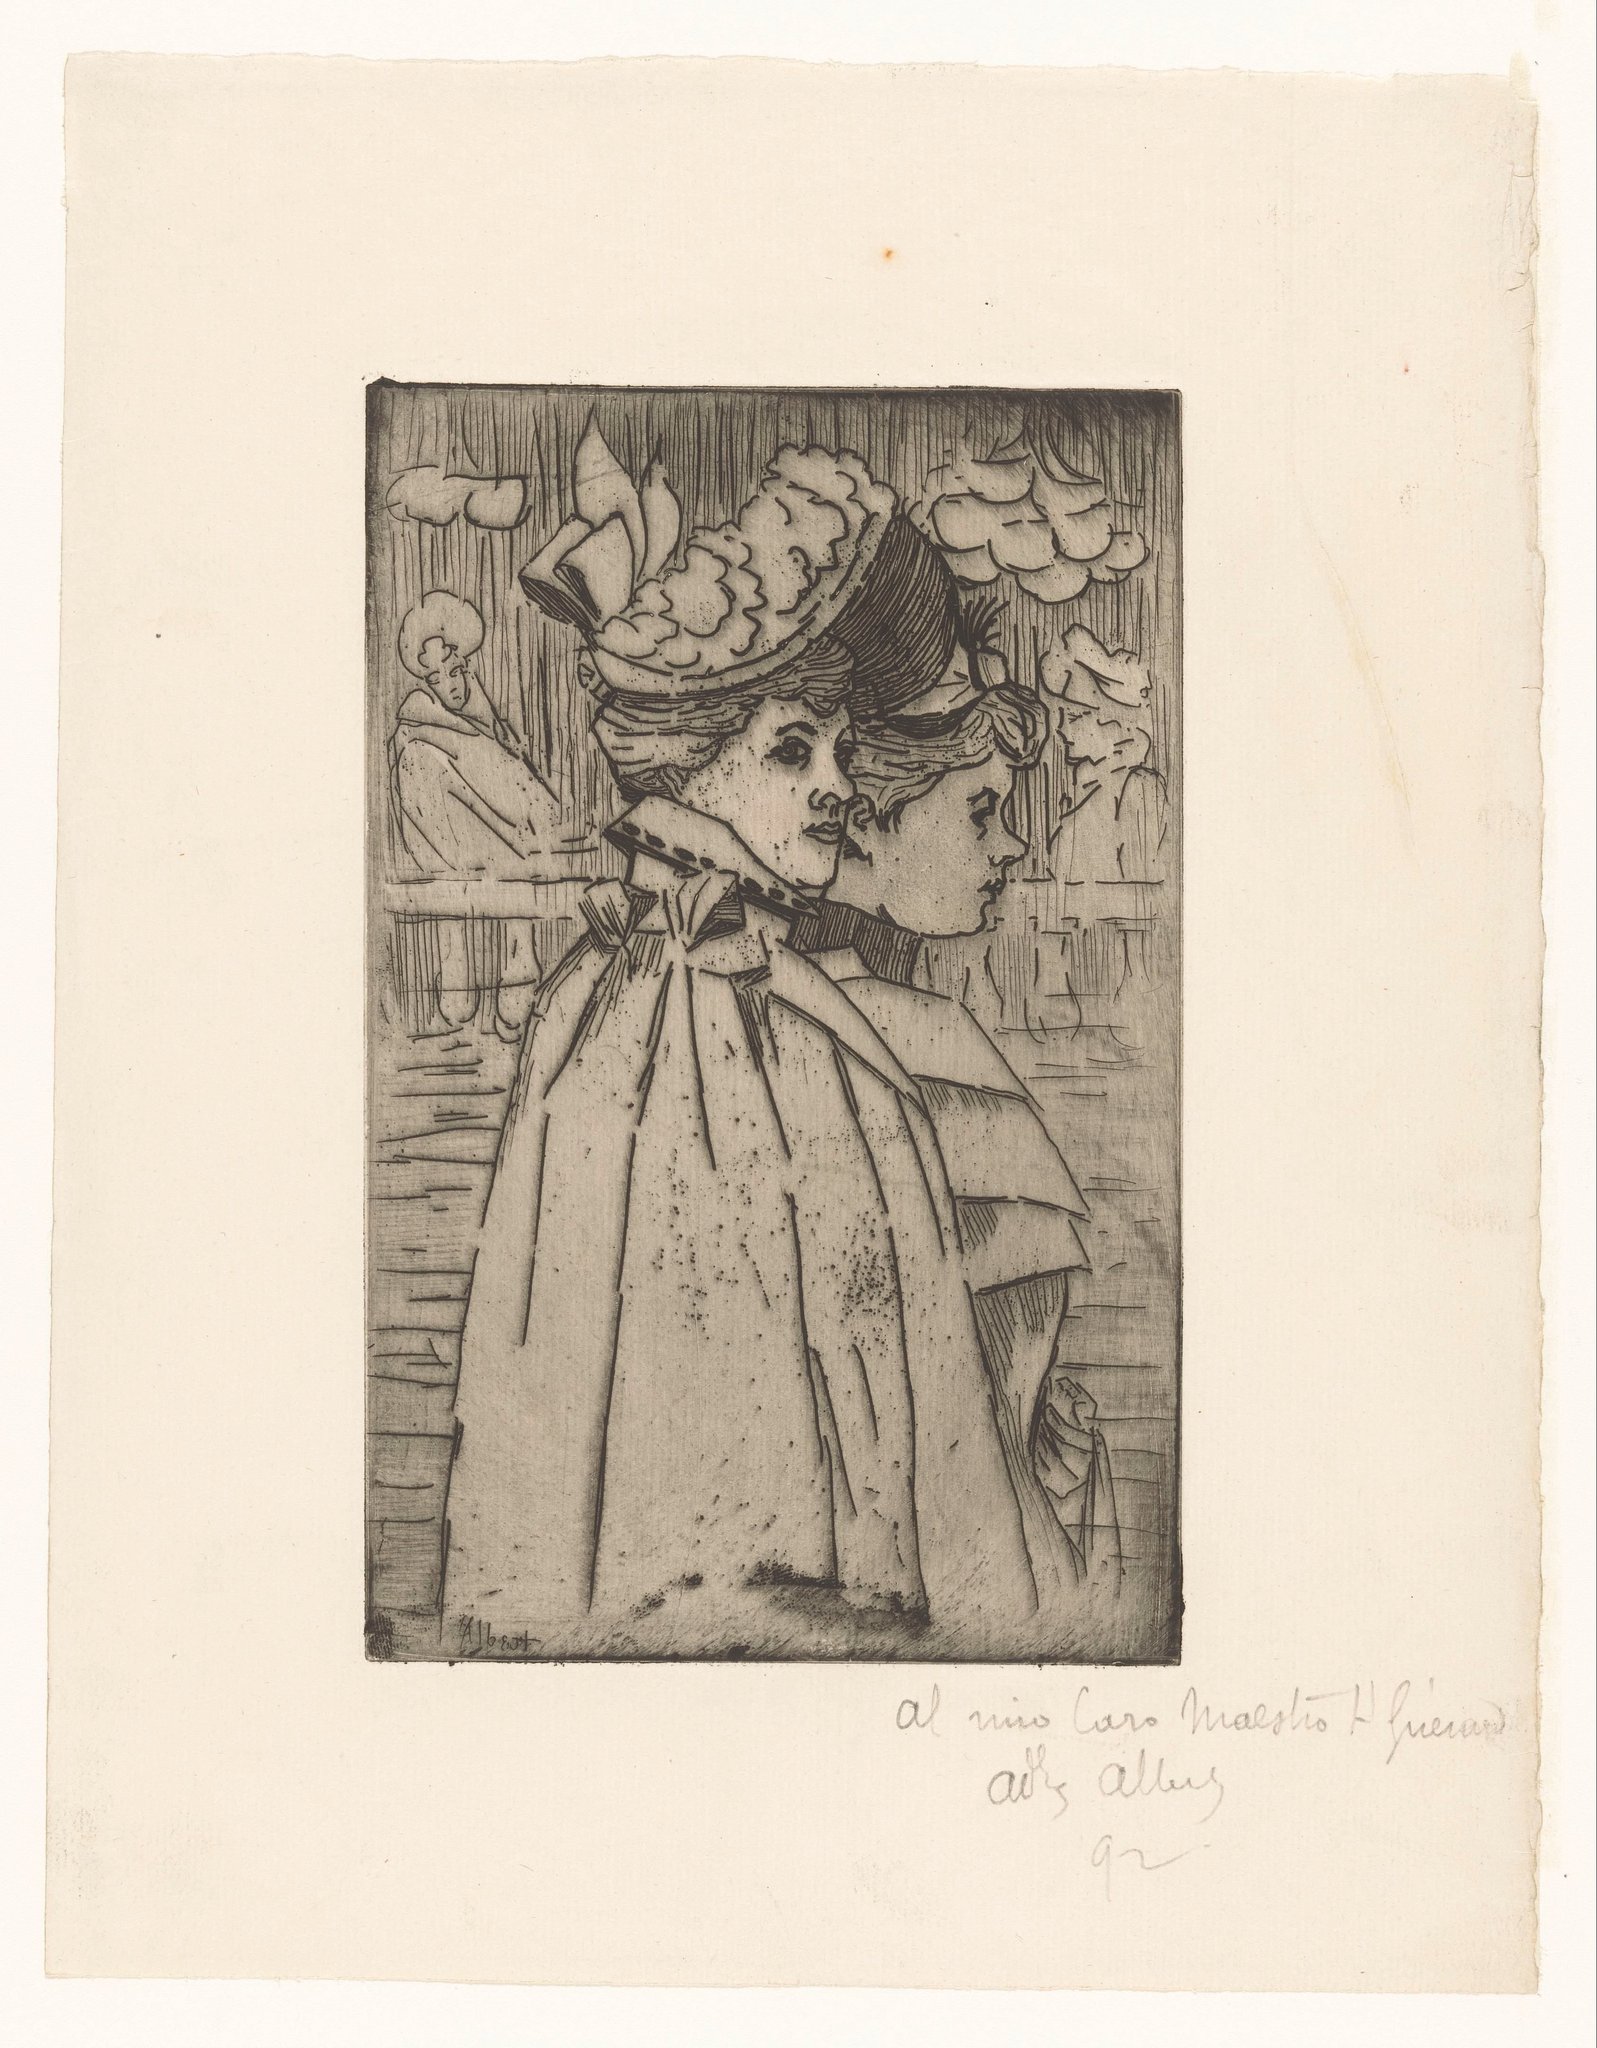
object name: print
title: Twee vrouwen ten halve lijve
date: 1892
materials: paper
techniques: etching, intaglio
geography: france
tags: adult woman, head-gear: hat, standing figure - aa - female human figure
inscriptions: collector's mark: Lugt 2228, collector's mark: Lugt 2760, inscription: ‘Al mio Caro Maestro H. Guérard [?] / Adolphe Albert / 92.’